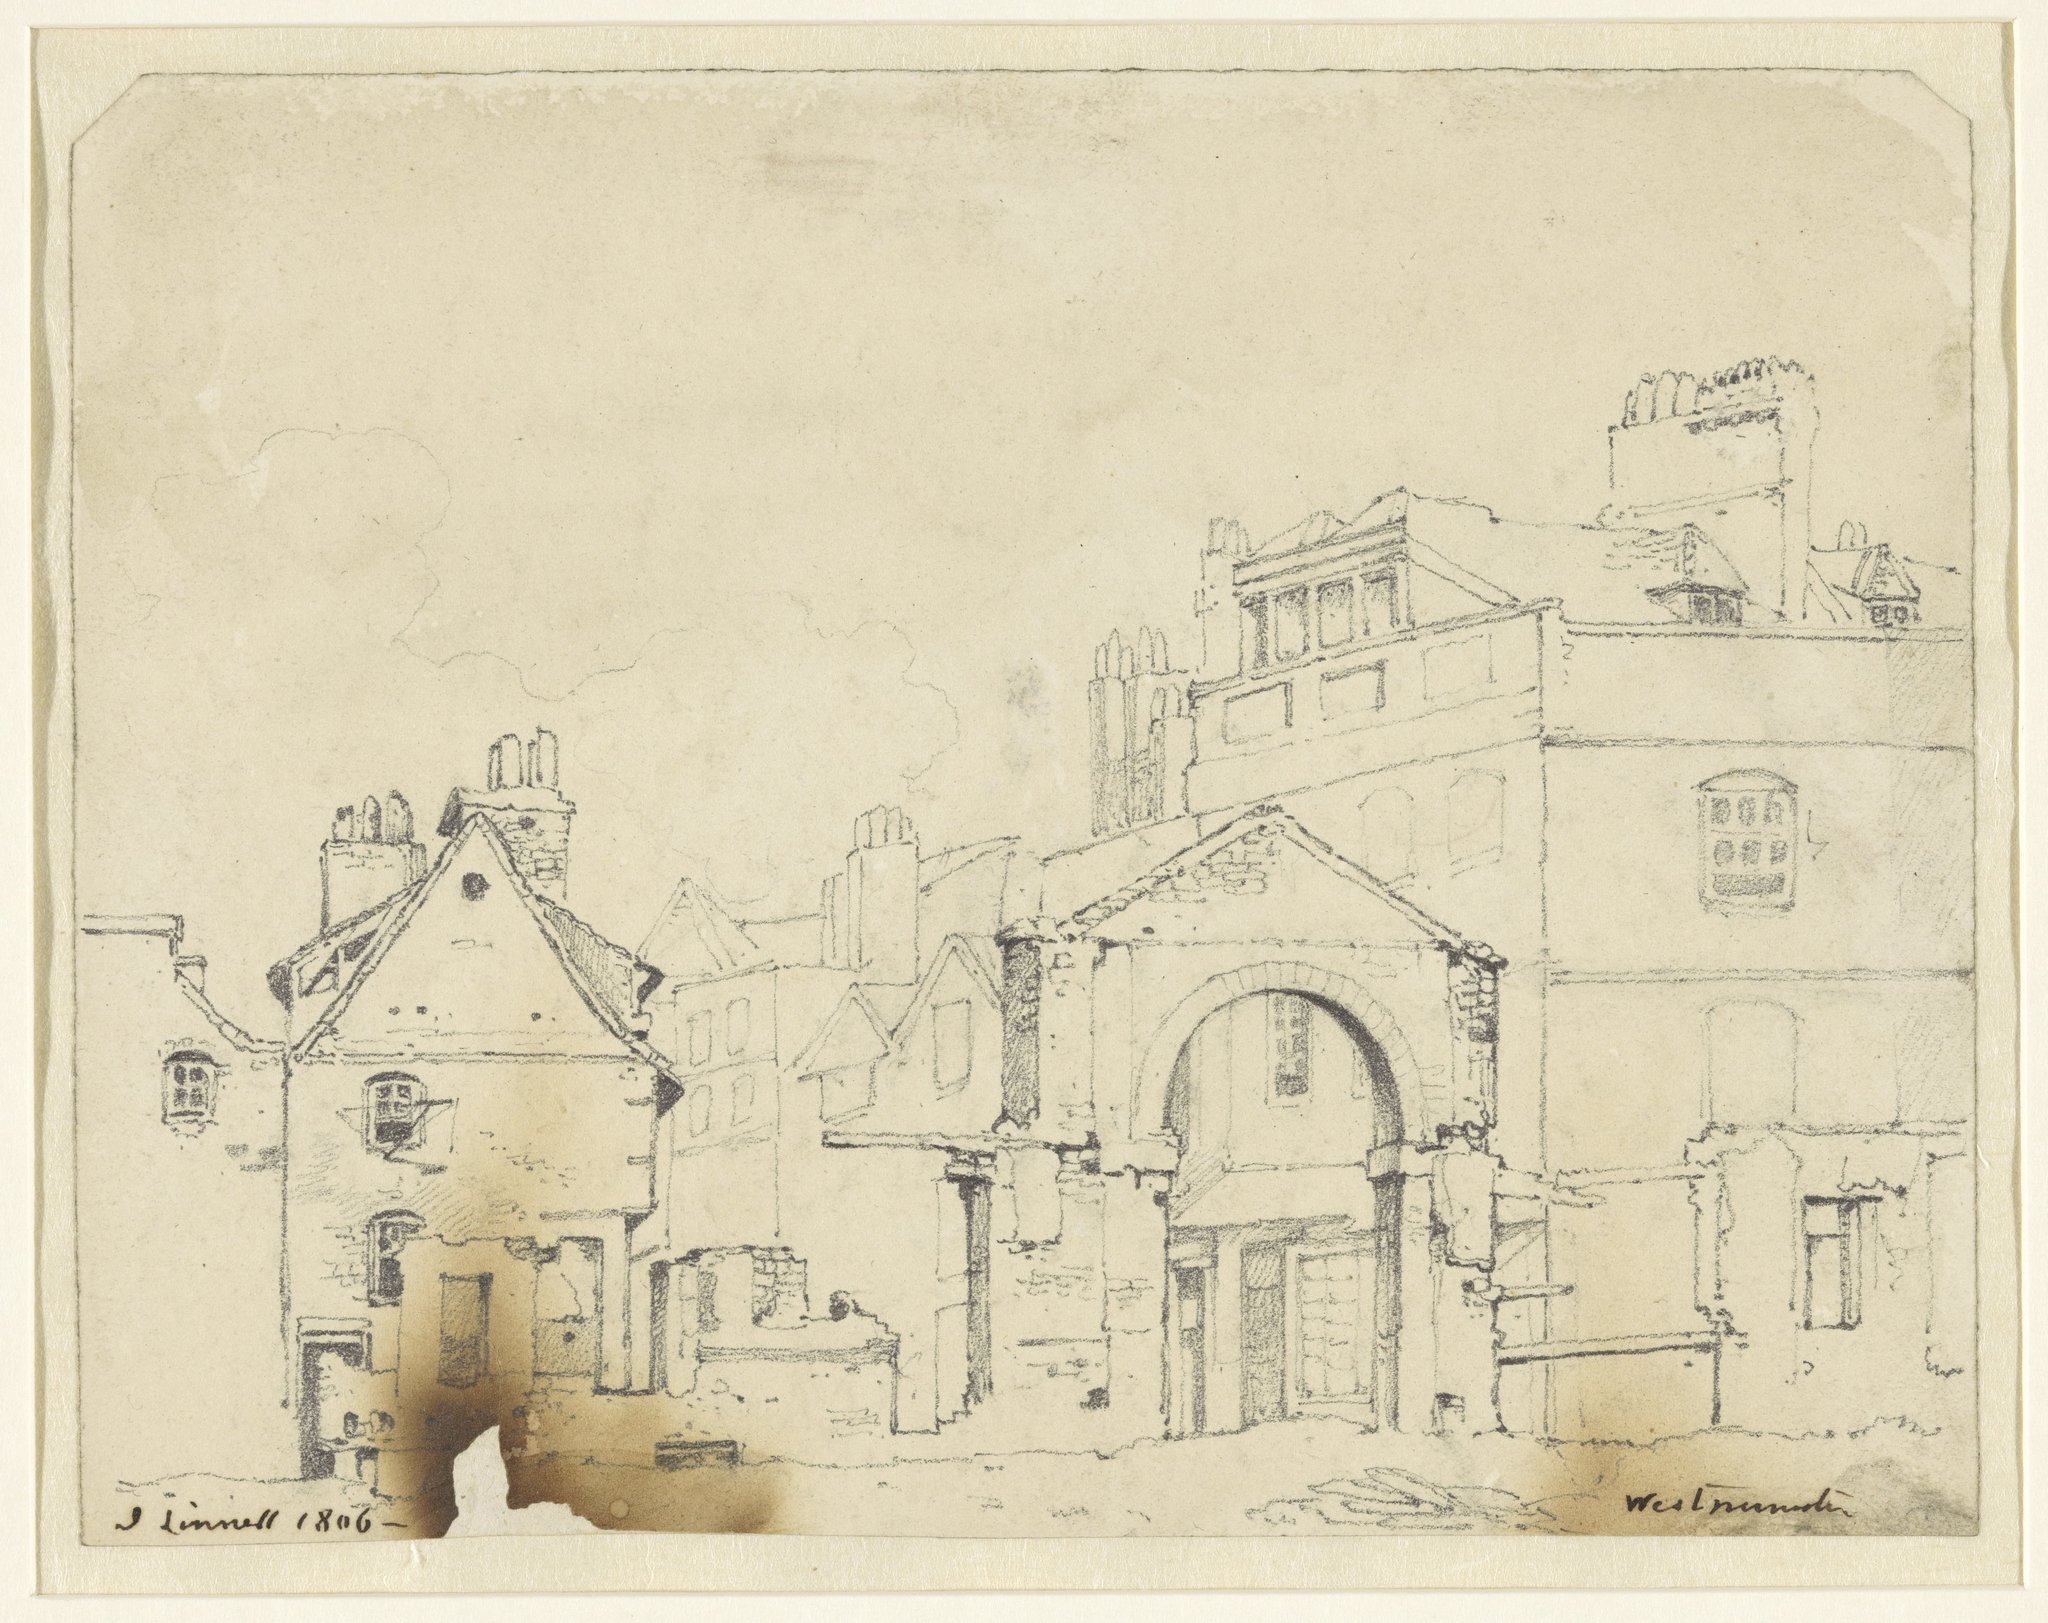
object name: drawing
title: Huizen en een poort in Westminster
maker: john linnell (ii)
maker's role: draughtsman, print maker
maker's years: 1792-1882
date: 1806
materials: paper, pencil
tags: street (+ city(-scape) with figures, staffage)